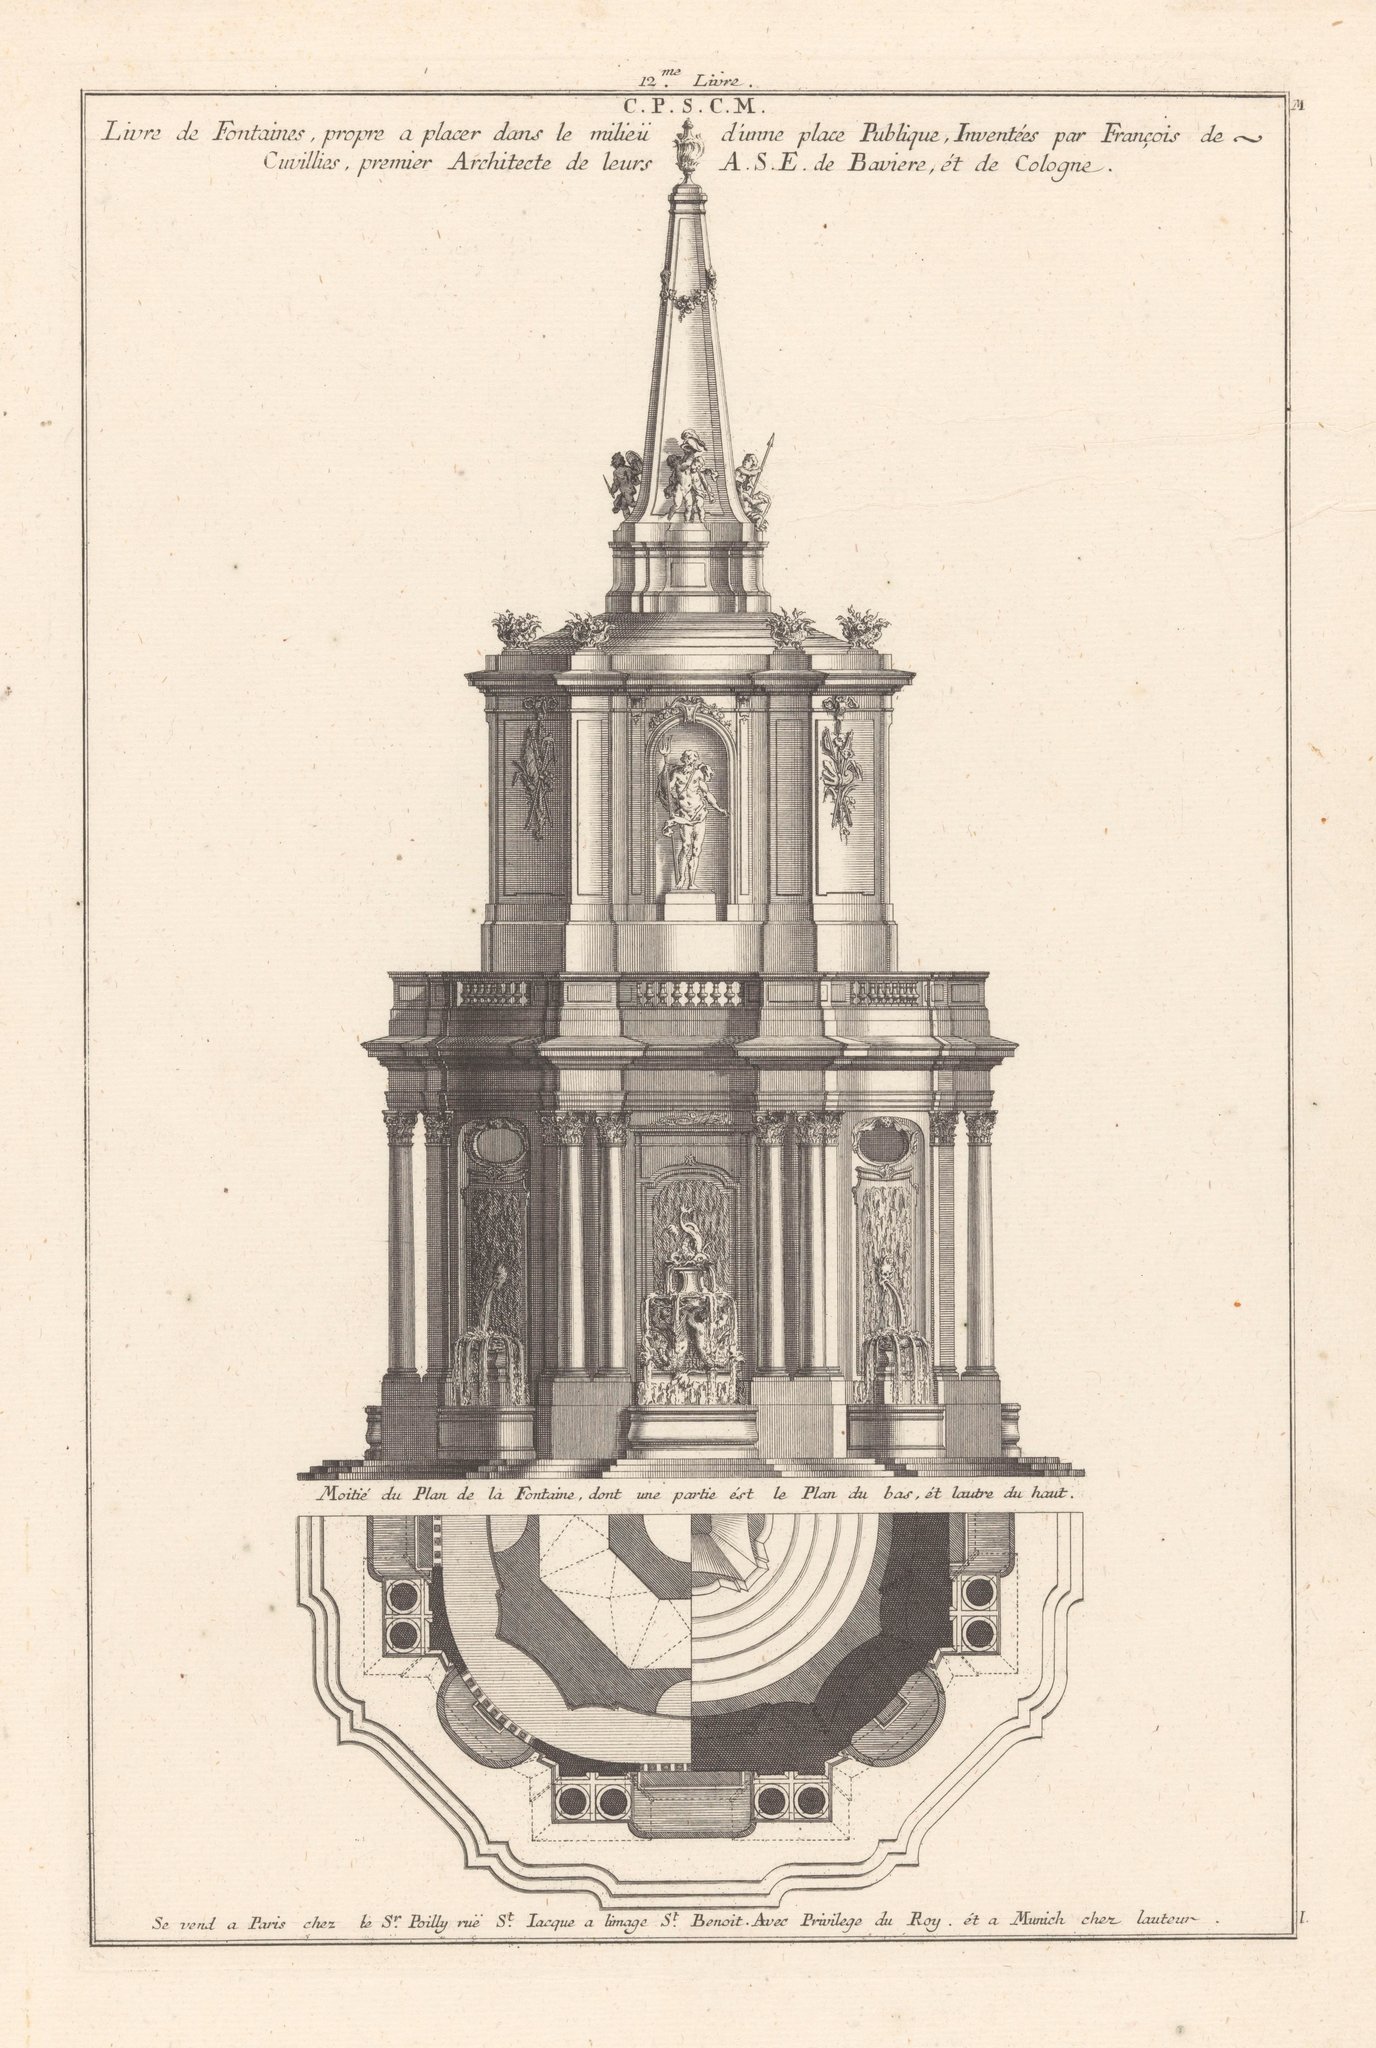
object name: ornament print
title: Fontein met Neptunus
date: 1745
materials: paper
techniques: engraving, etching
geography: paris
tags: (story of) neptune (poseidon), dolphin ~ ornament, ornamental fountain, cupids: 'amores', 'amoretti', 'putti'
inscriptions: collector's mark: Lugt 2228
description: Ontwerp en plattegrond van een fontein met putti en Neptunus. Aan de onderzijde drie kleine fonteinen met maskers, dolfijnen en meermannen.